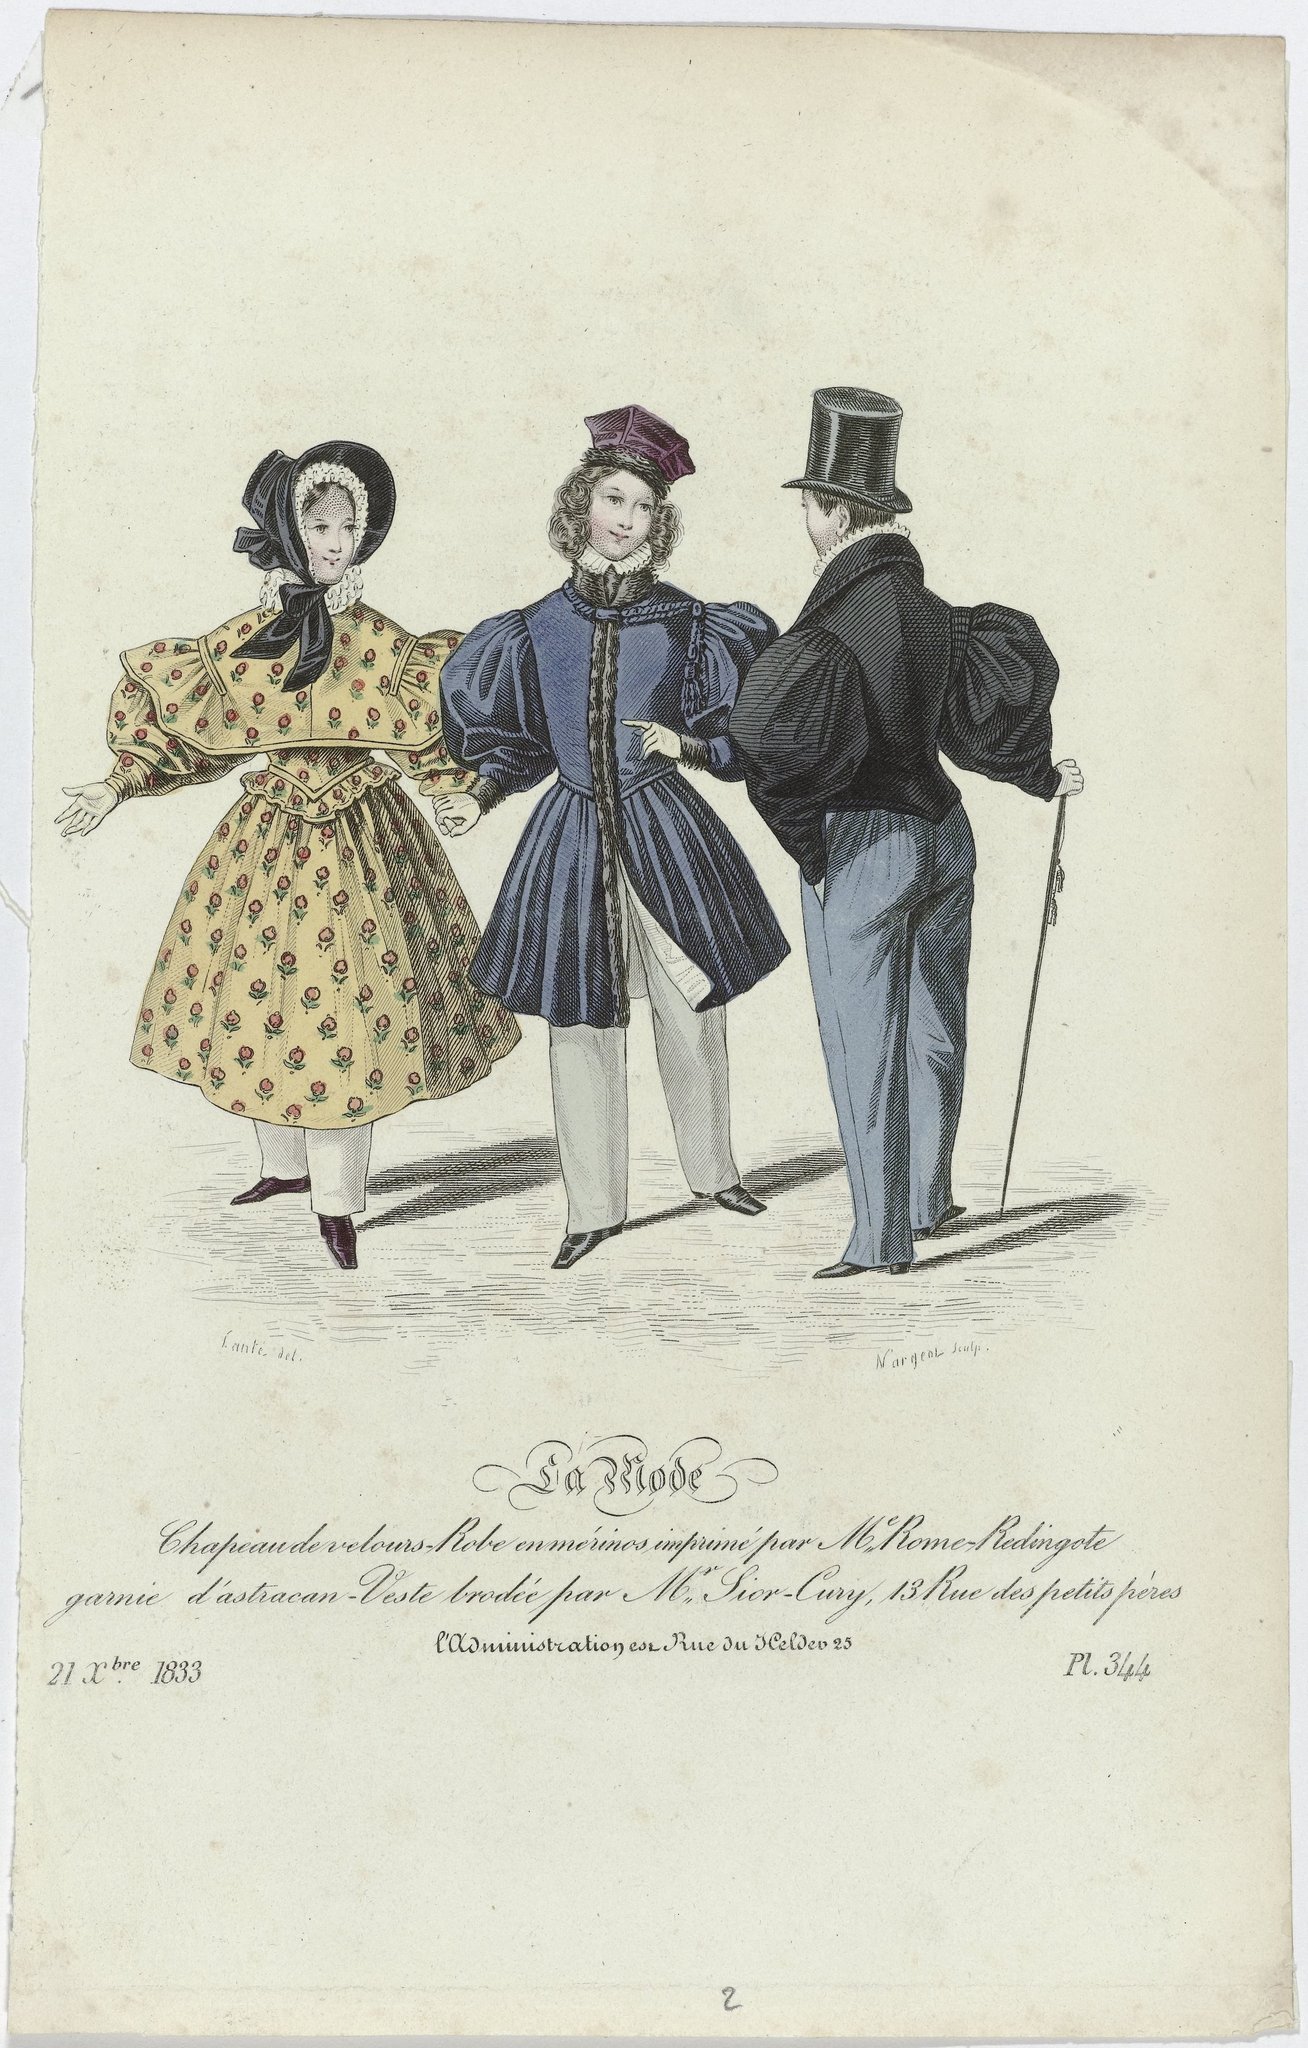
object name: fashion print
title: La Mode, 21 décembre 1833, Pl. 344 : Chapeau de velours-Rob (...)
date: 1833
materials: paper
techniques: hand coloring, engraving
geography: paris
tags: walking-stick, staff, cane (+ girls' clothes), head-gear: hat (+ girls' clothes), trousers, breeches (+ boys' clothes), shoes, sandals (+ boys' clothes), clothing for the upper part of the body (+ boys' clothes), shoes, sandals (+ girls' clothes), underclothes for the lower part of the body: bloomers (+ girls' clothes), coat (+ boys' clothes), fashion plates, dress, gown (+ girls' clothes)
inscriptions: caption: ‘Chapeau de velours - Robe en mérinos imprimé par M"e Rome-Redingote garnie d'astracan-Veste brodée par M"r Sior-Cury, 13 Rue des Petits pères’, address: ‘L'Administration est Rue du Helder 25.’, title: ‘La Mode.’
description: Kinderkleding: hoed van fluweel. Japon van bedrukte merinowol door Me Rome. Redingote afgezet met astrakan. Jasje met borduurwerk van Mr Sior -Cury. Prent uit het modetijdschrift La Mode (1829-1855).